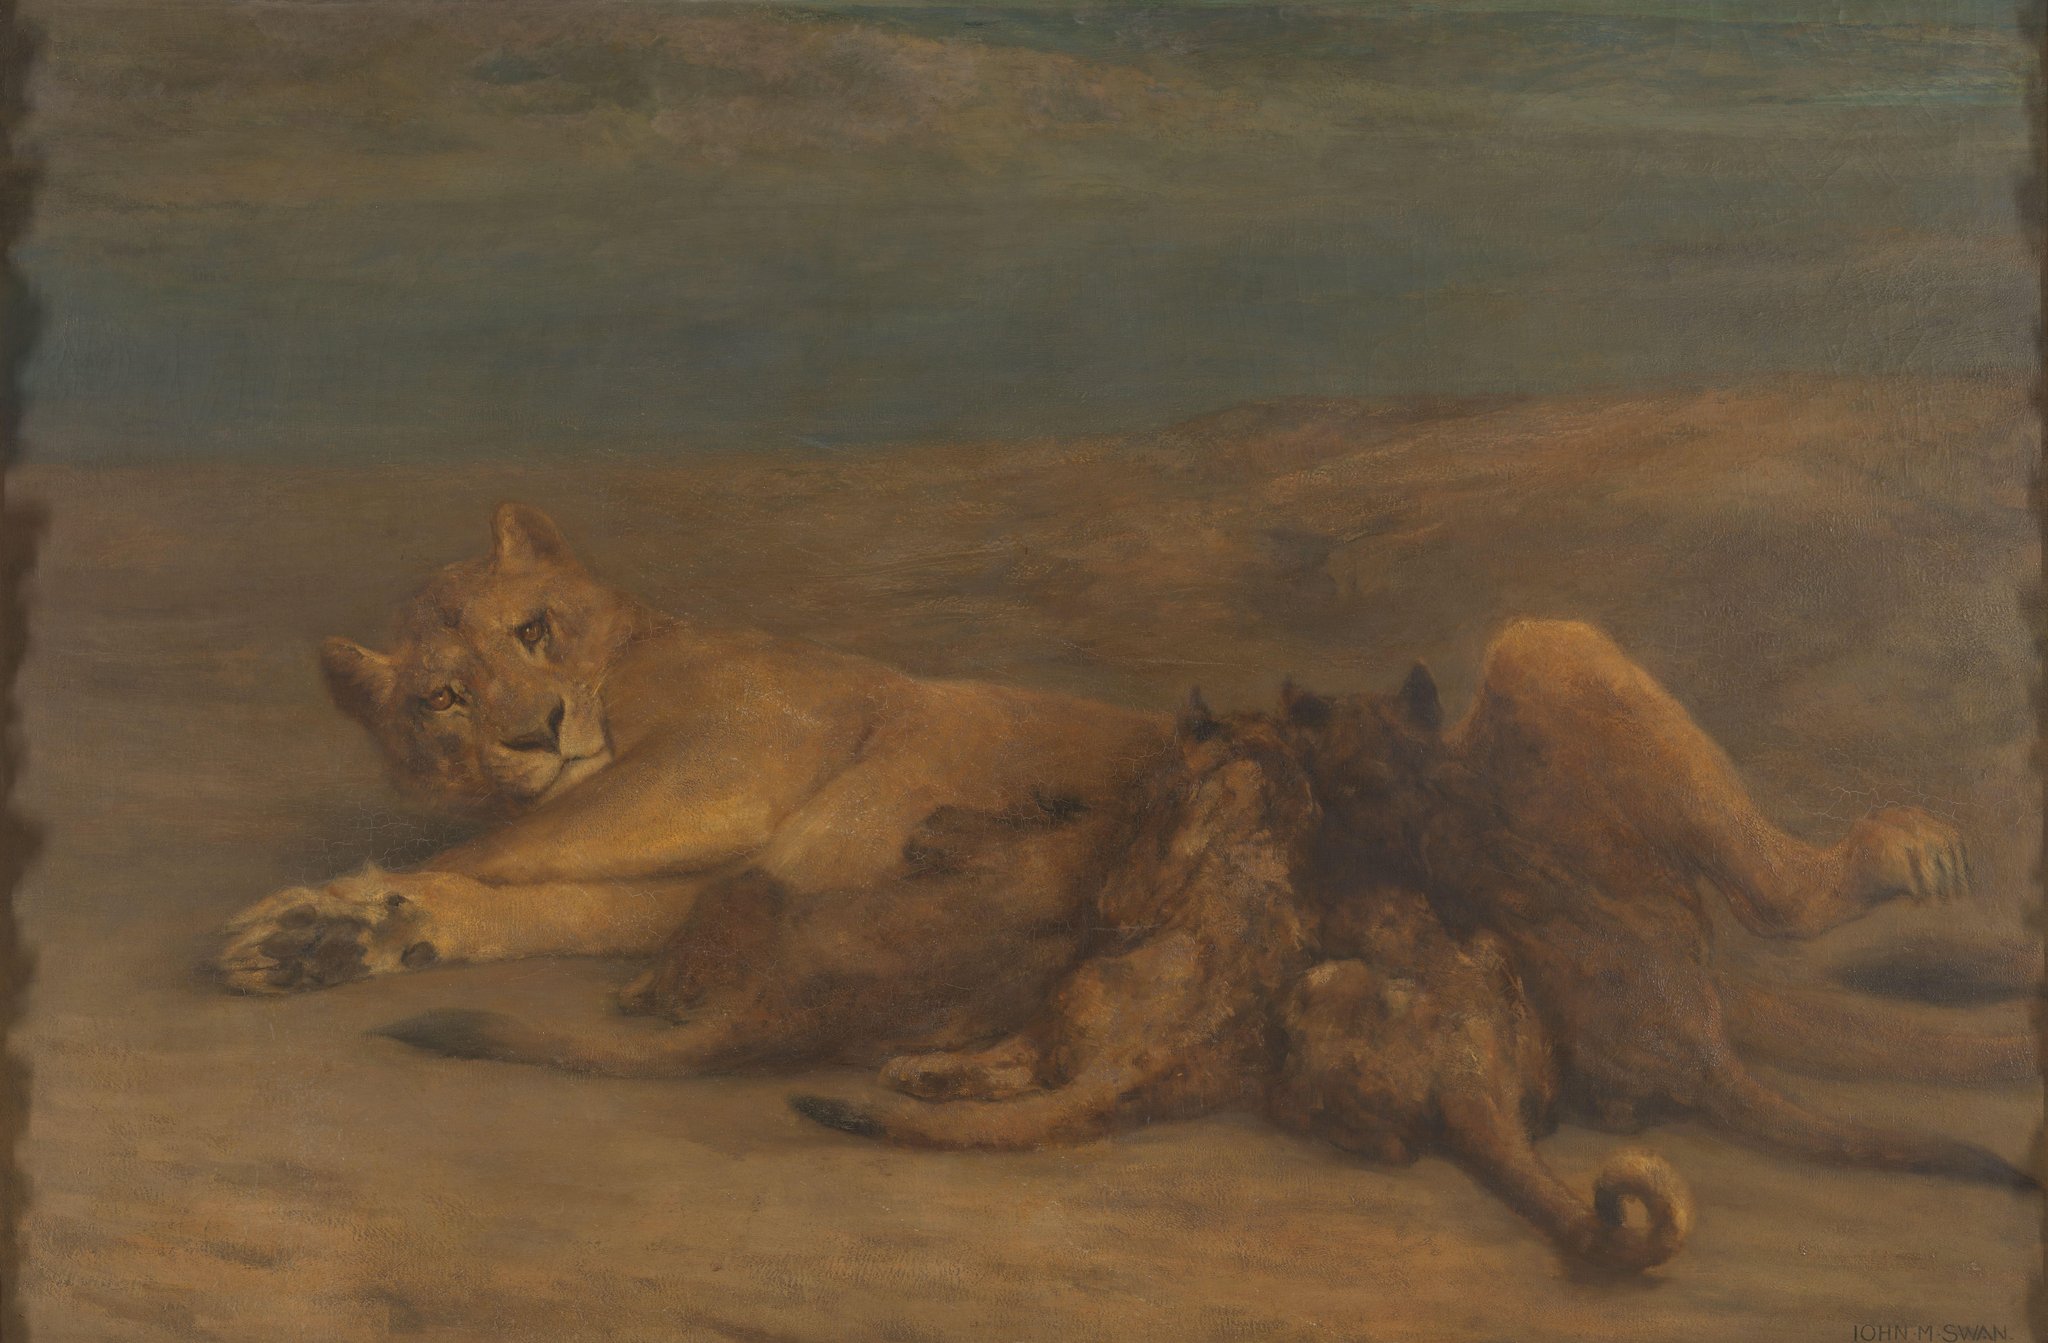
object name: painting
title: Een leeuwin met vier zogende welpen, genaamd 'Moederliefde'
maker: john macallan swan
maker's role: draughtsman, painter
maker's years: 1847-1910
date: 1870-1904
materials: canvas, oil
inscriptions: signature: ‘John. M. Swan.’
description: Voorstelling getiteld 'Moederliefde'. Een liggende leeuwin met vier zogende welpen.